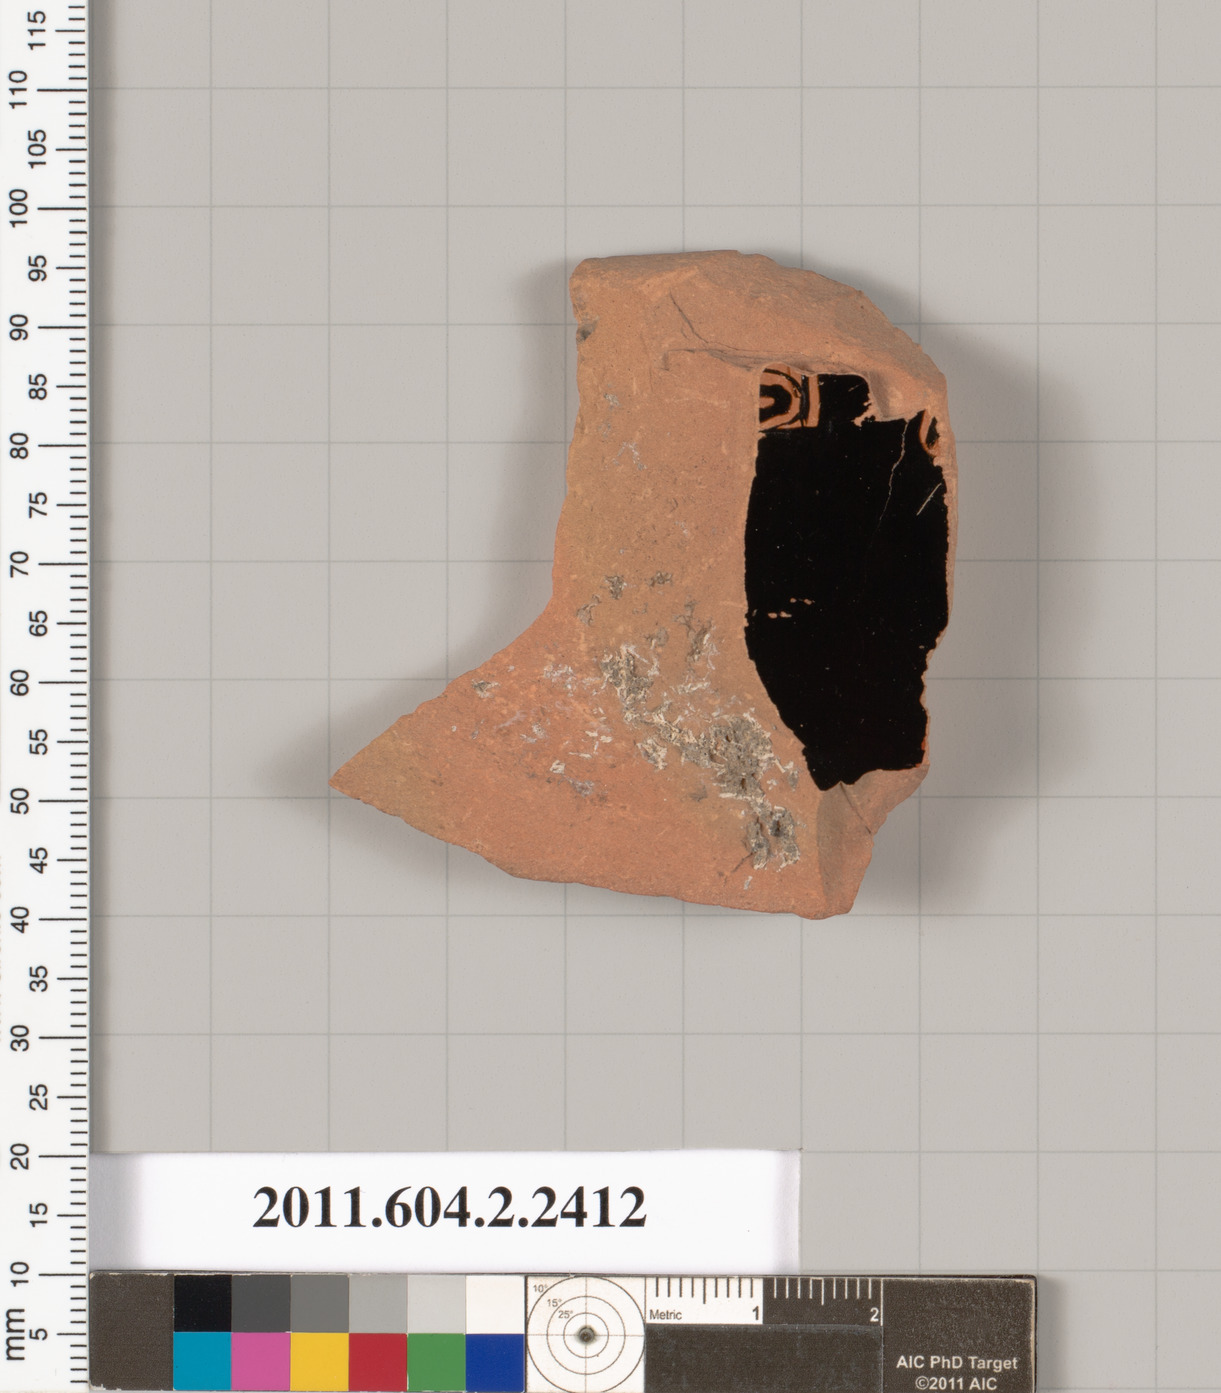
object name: bell krater fragment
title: Terracotta fragment of a bell-krater (bowl for mixing wine and water)?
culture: greek, attic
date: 450-401 BCE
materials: terracotta